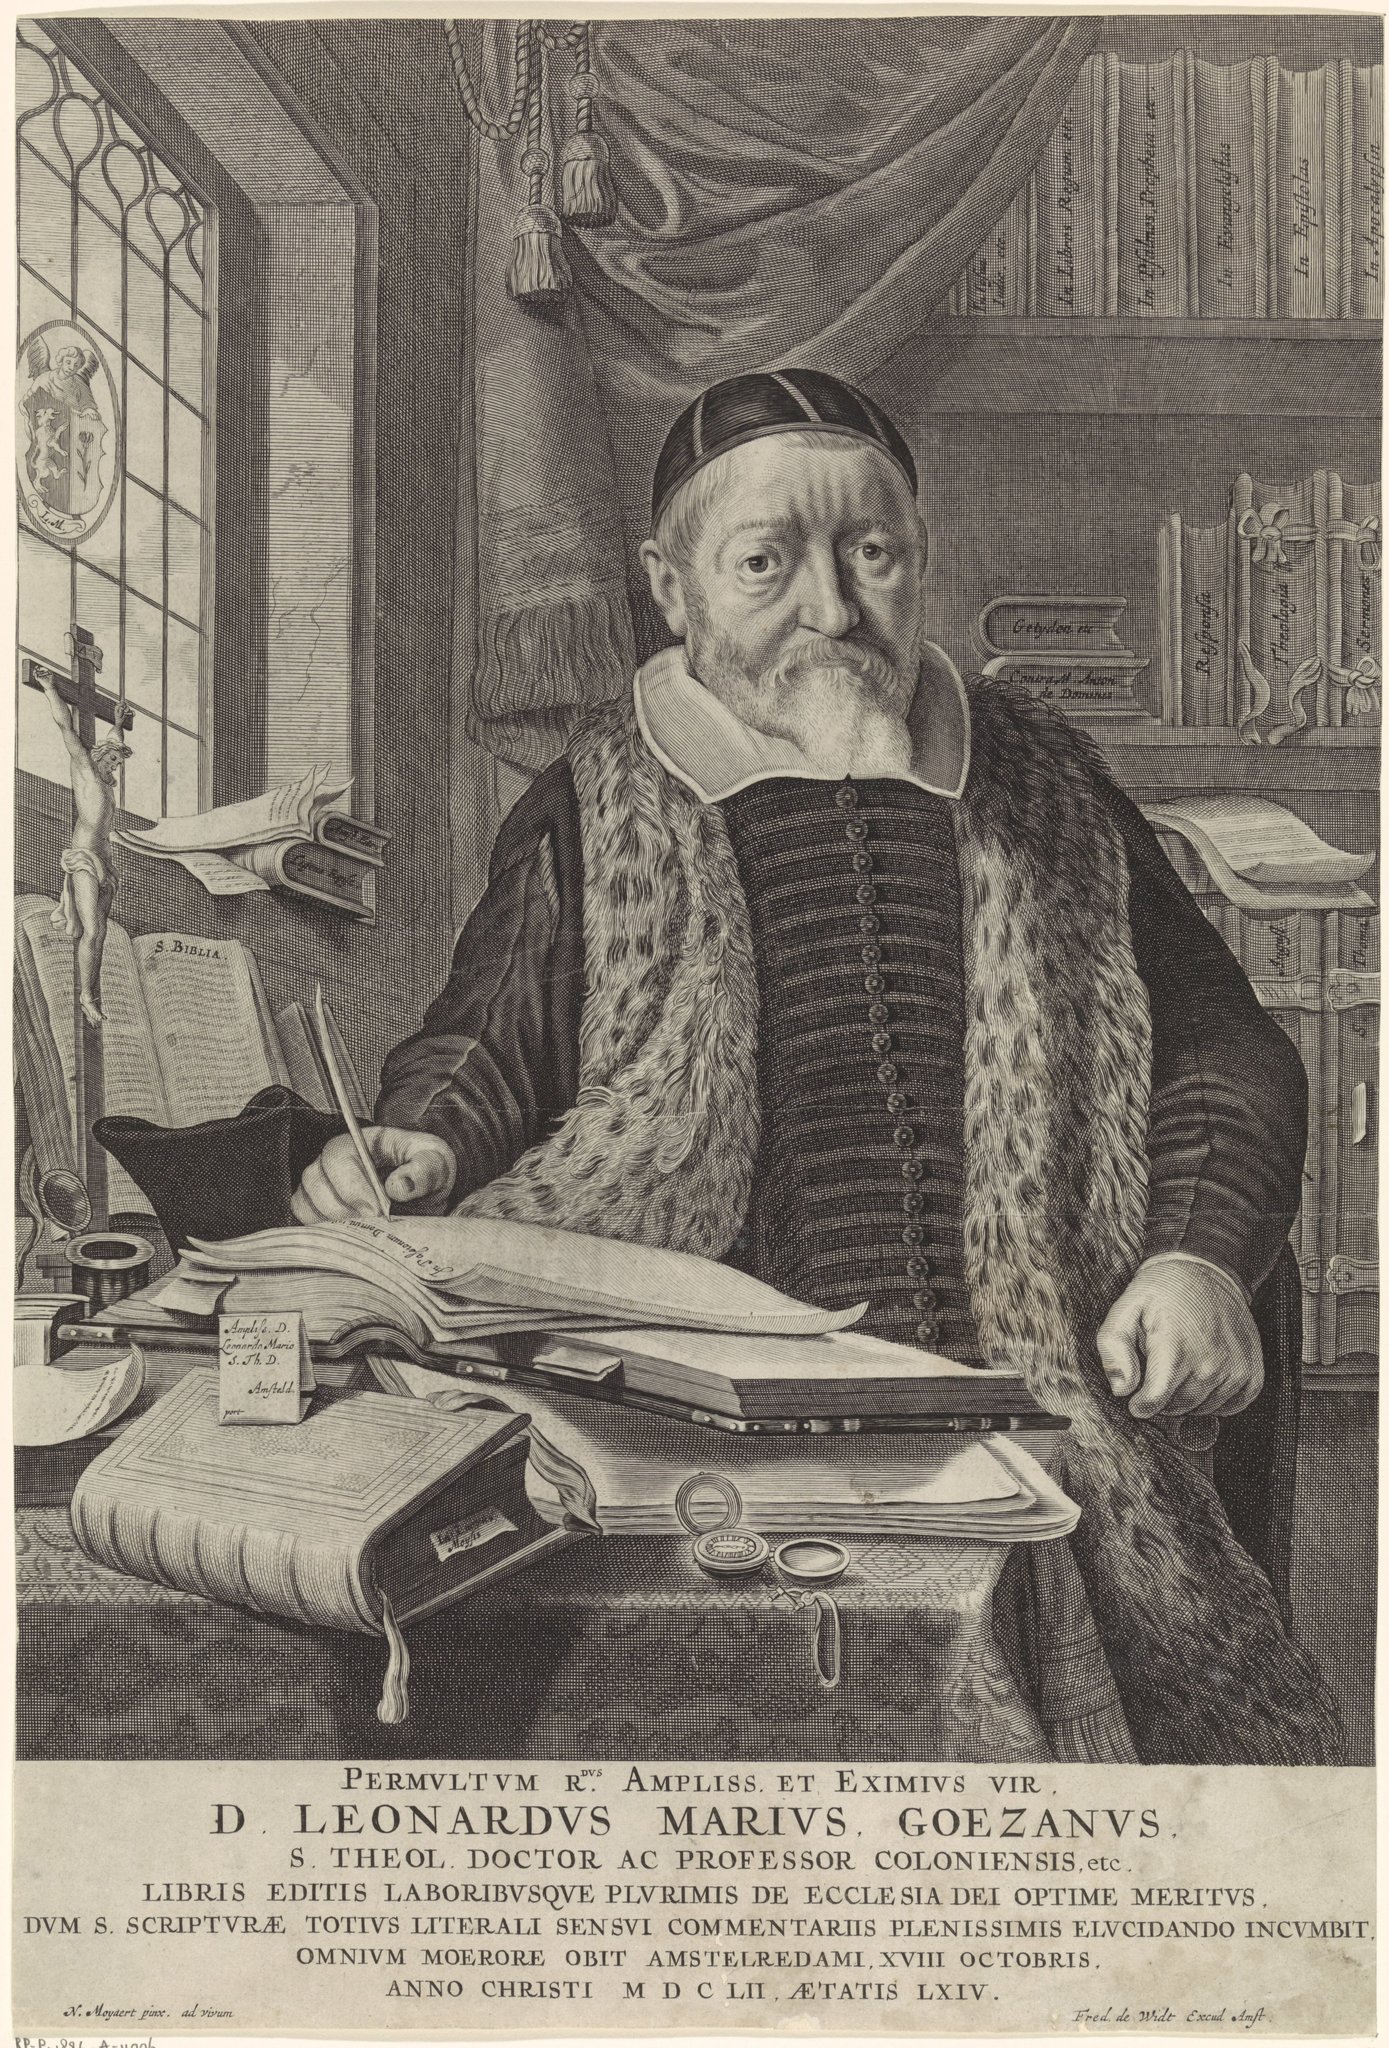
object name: print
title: Portret van Leonard Marius van der Goes in een studeervertrek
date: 1652-1676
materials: paper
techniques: engraving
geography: amsterdam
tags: study; 'studiolo'; library, crucifix ~ personal devotion, watch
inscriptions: collector's mark: Lugt 2228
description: Portret van de Amsterdamse priester en theoloog Leonard Marius van der Goes in een studeervertrek.